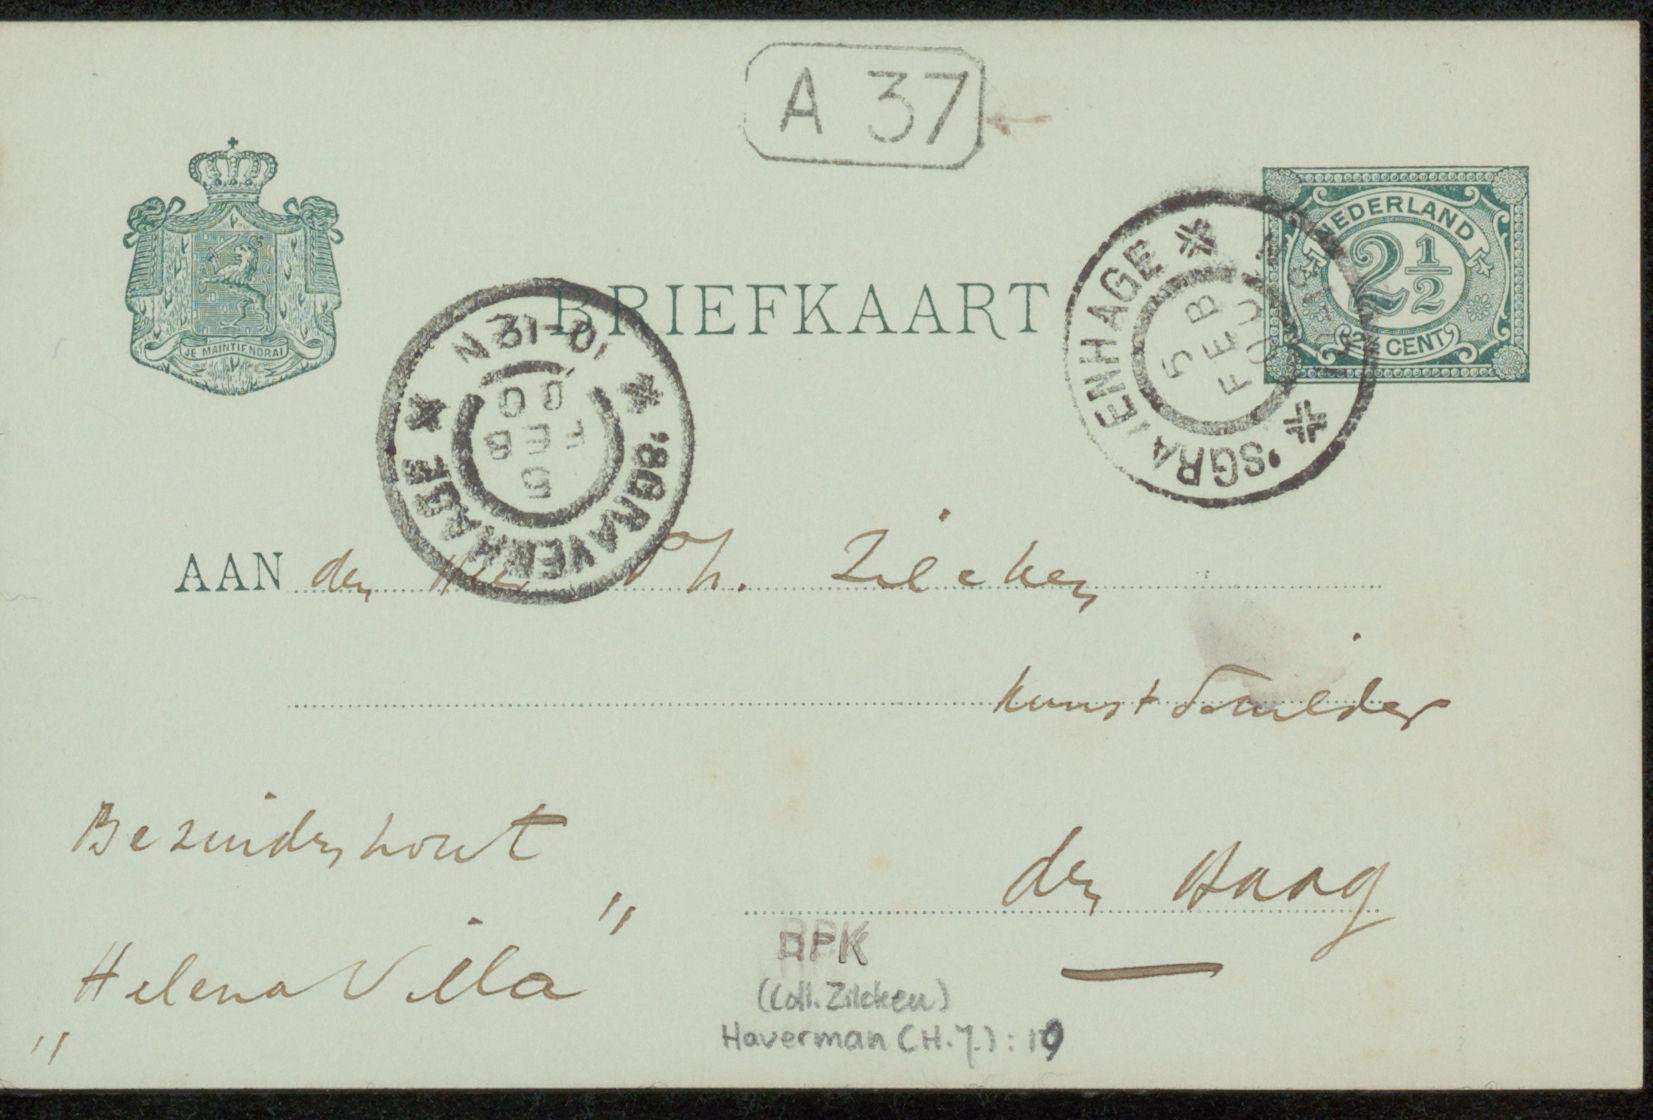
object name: postcard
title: Briefkaart aan Philip Zilcken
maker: hendrik johannes haverman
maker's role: draughtsman, print maker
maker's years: 1857-1928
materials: cardboard, ink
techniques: pen, writing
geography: the hague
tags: the hague, painter, draughtsman, philip zilcken, the graphic arts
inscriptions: collector's mark: ‘RPK’